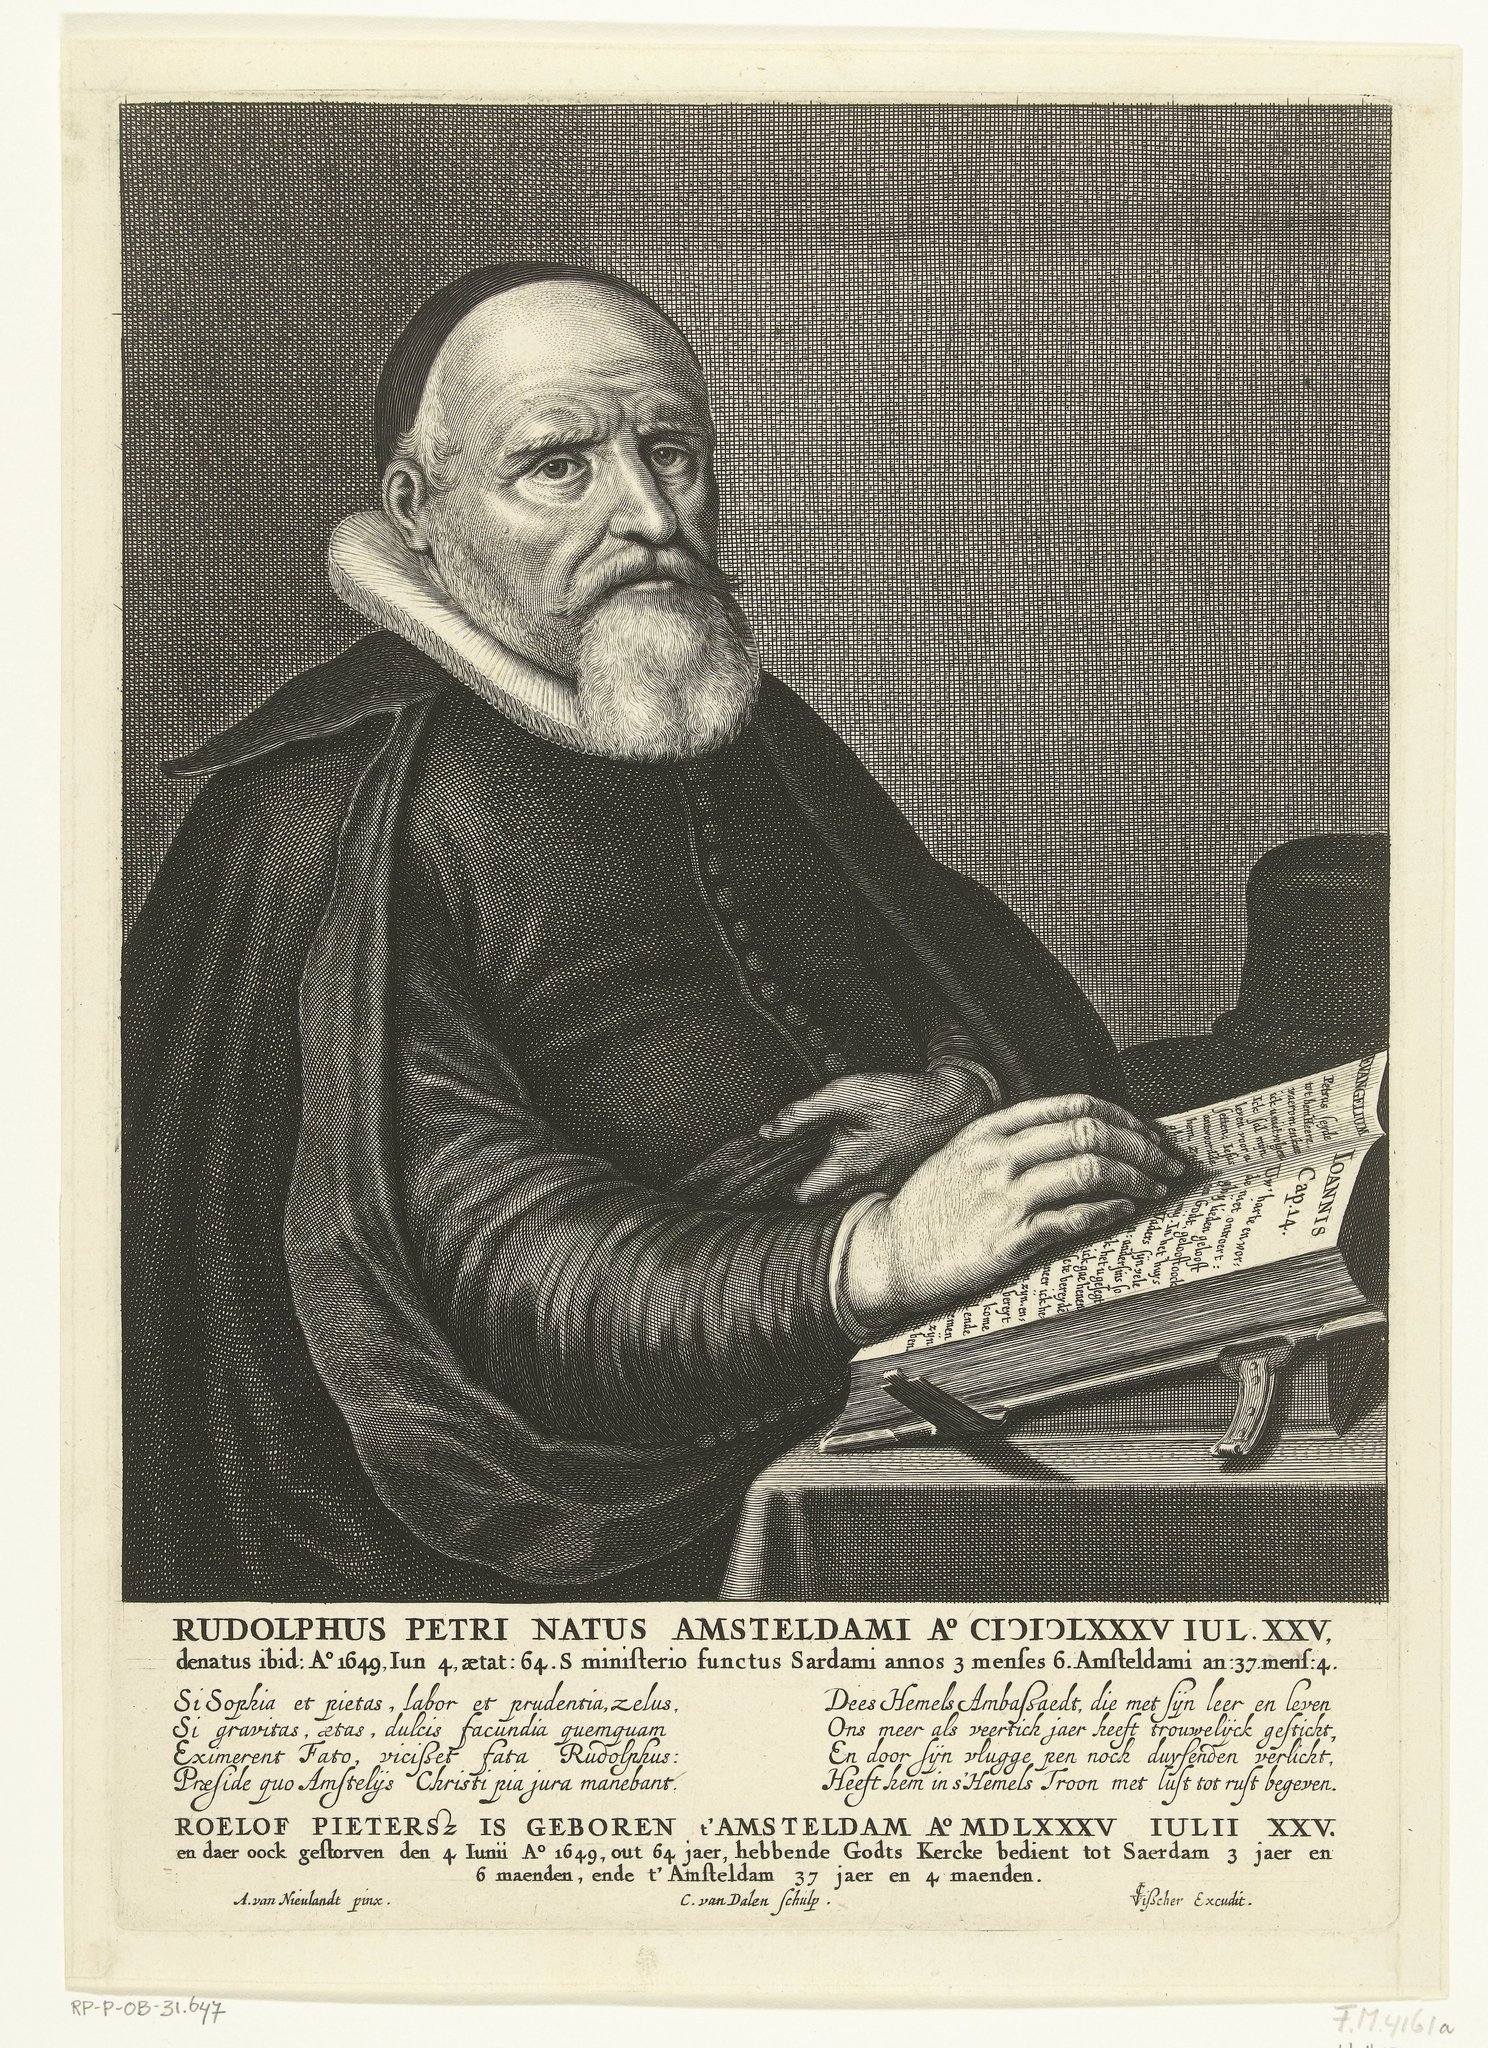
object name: print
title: Portret van Rudolphus Petri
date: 1649-1665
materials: paper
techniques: engraving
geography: amsterdam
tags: historical persons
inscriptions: collector's mark: Lugt 240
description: Portret van hoogleraar theologie Roelof Pietersz. Ten halven lijve zittend met bijbel, gekleed in toga. Onder in de marge Latijns en Nederlands vers.